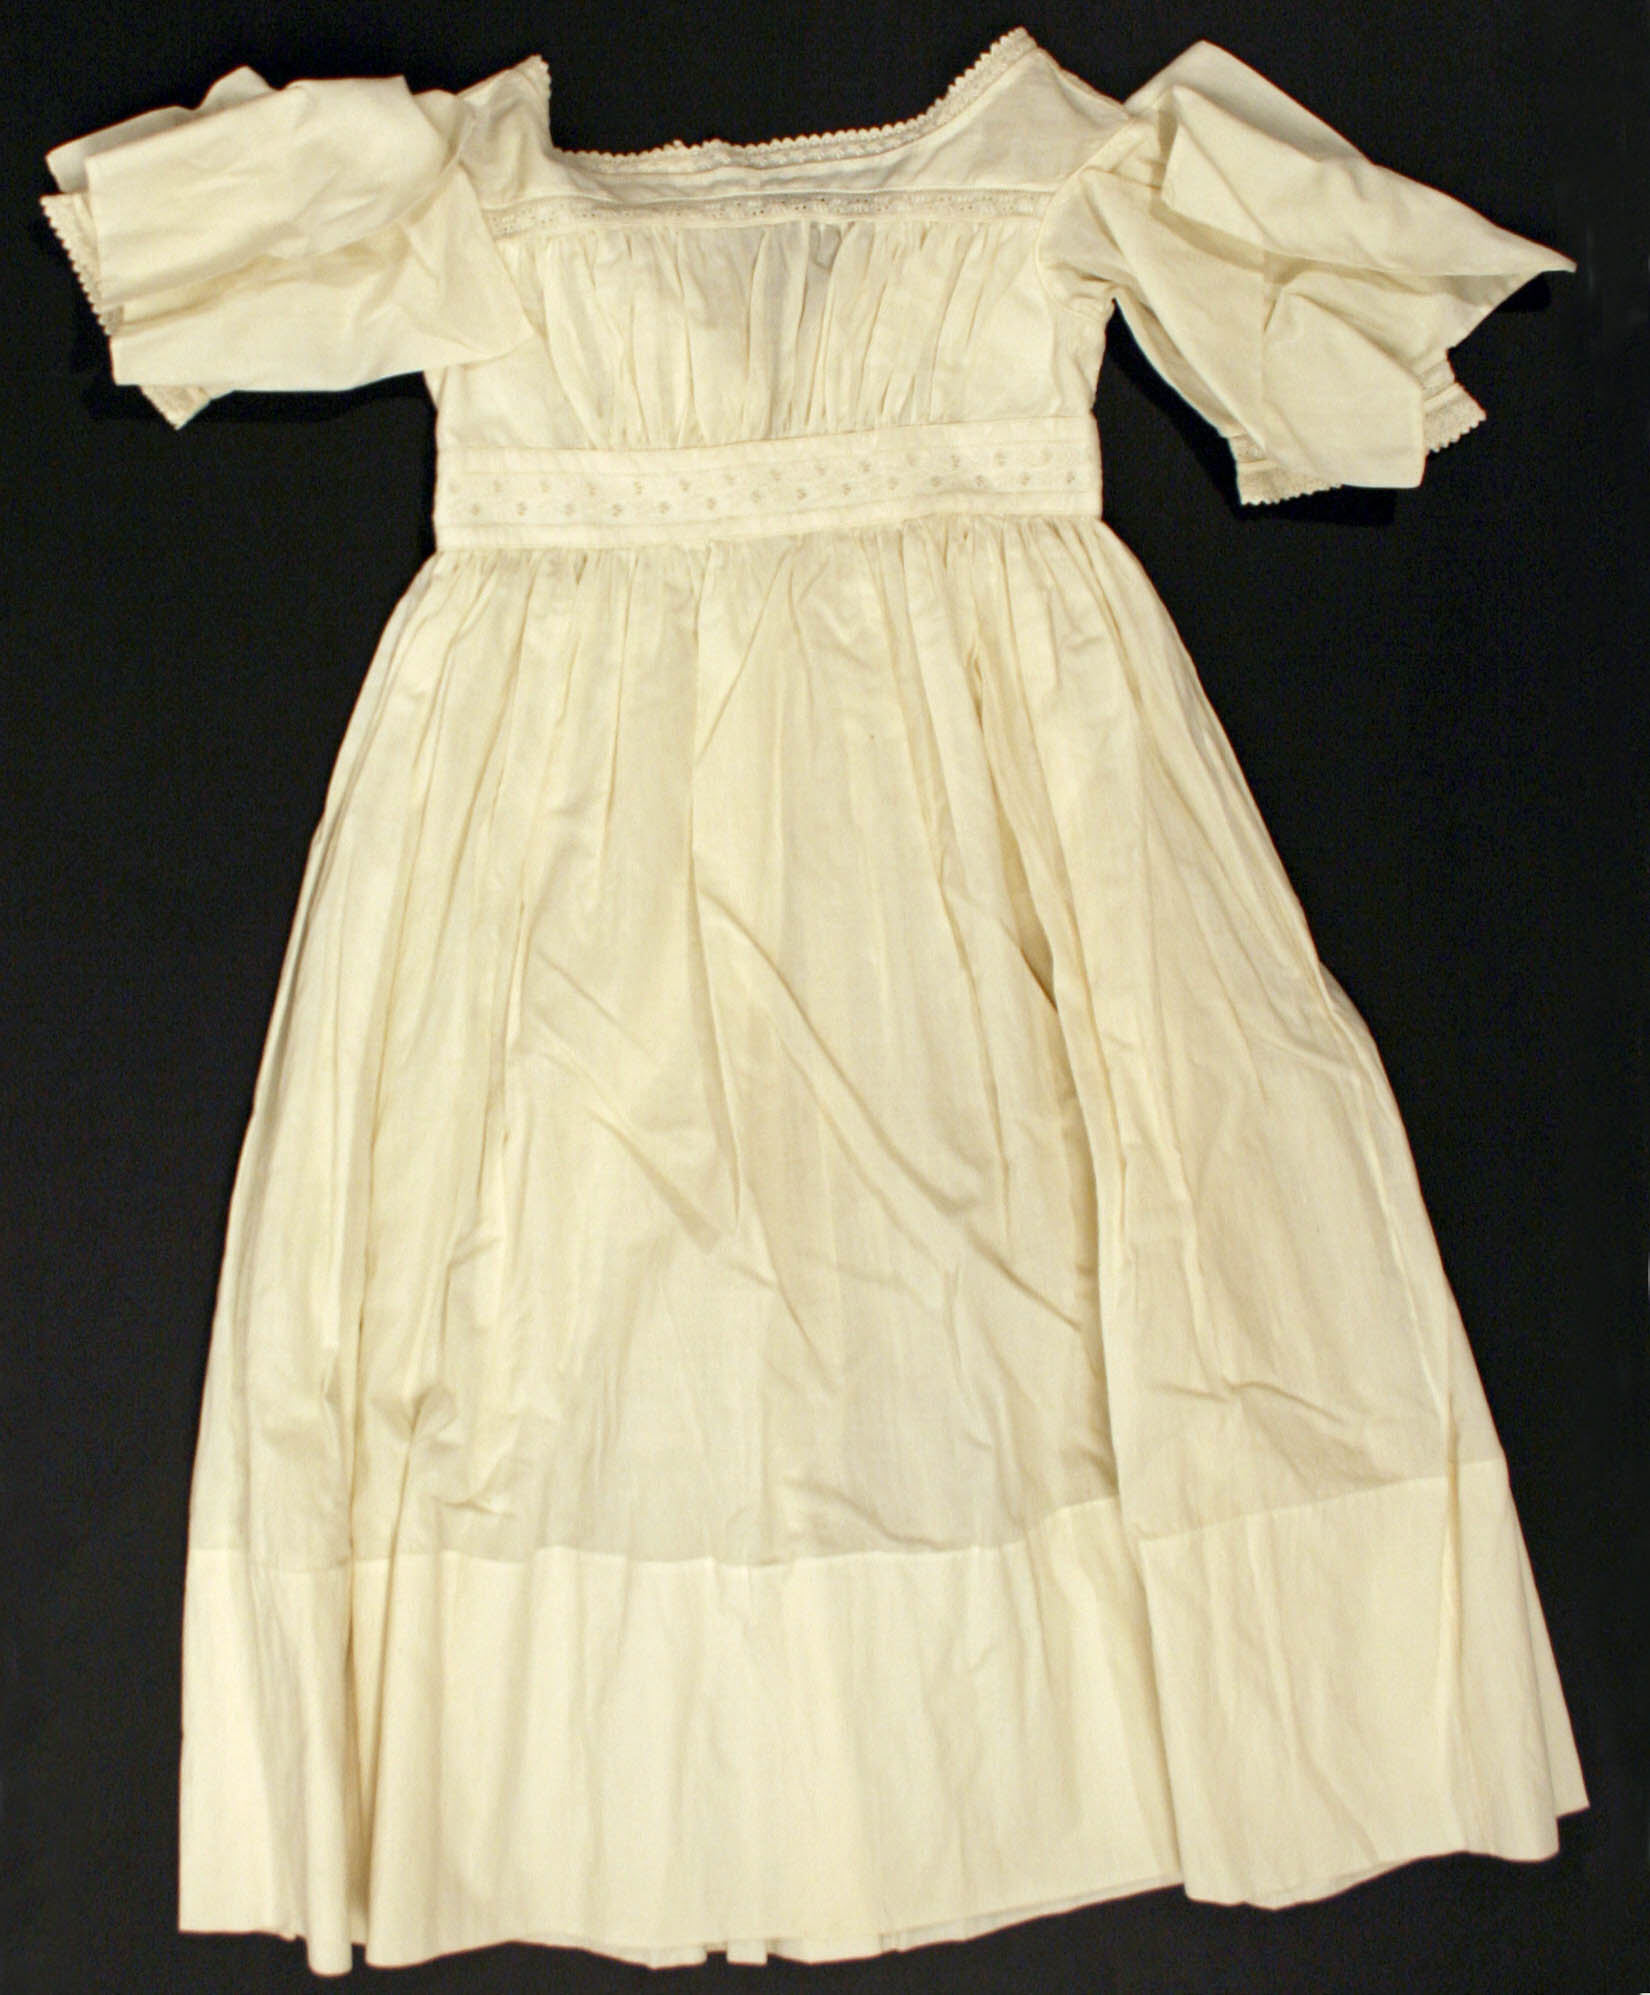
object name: dress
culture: american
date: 1840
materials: cotton